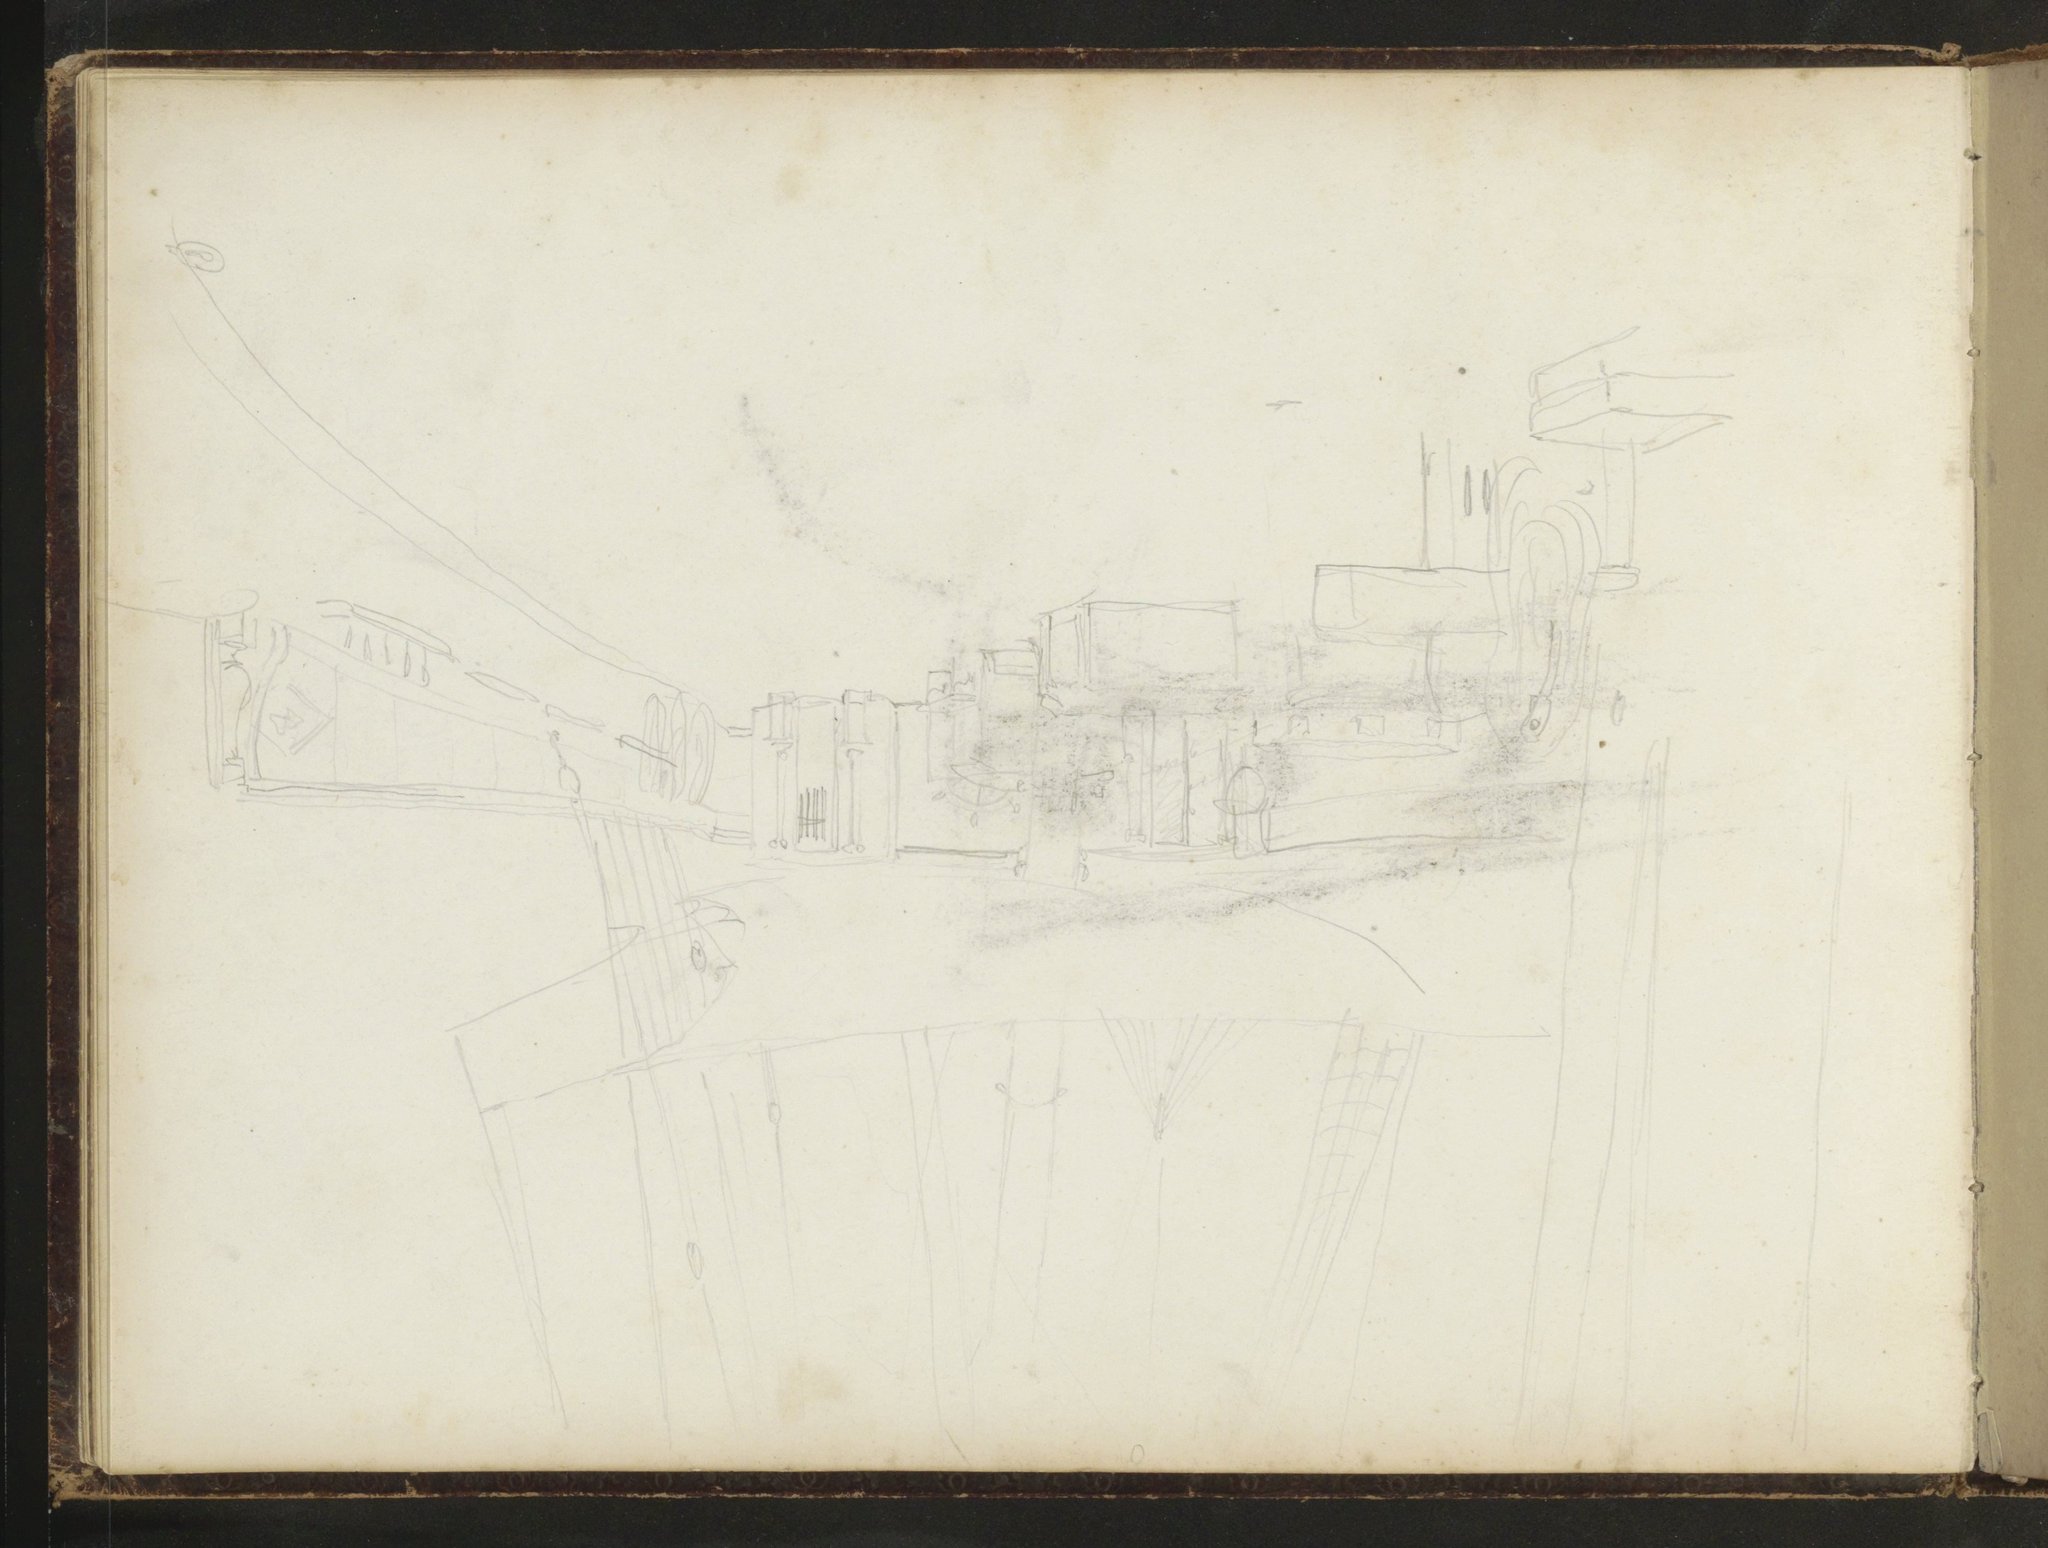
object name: sketchbook leaf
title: Dek van een schip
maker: reinier craeyvanger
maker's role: draughtsman, print maker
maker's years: 1812-1880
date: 1822-1880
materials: paper, pencil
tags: parts of ship's exterior: deck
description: Blad 14 verso uit een schetsboek met 45 bladen.